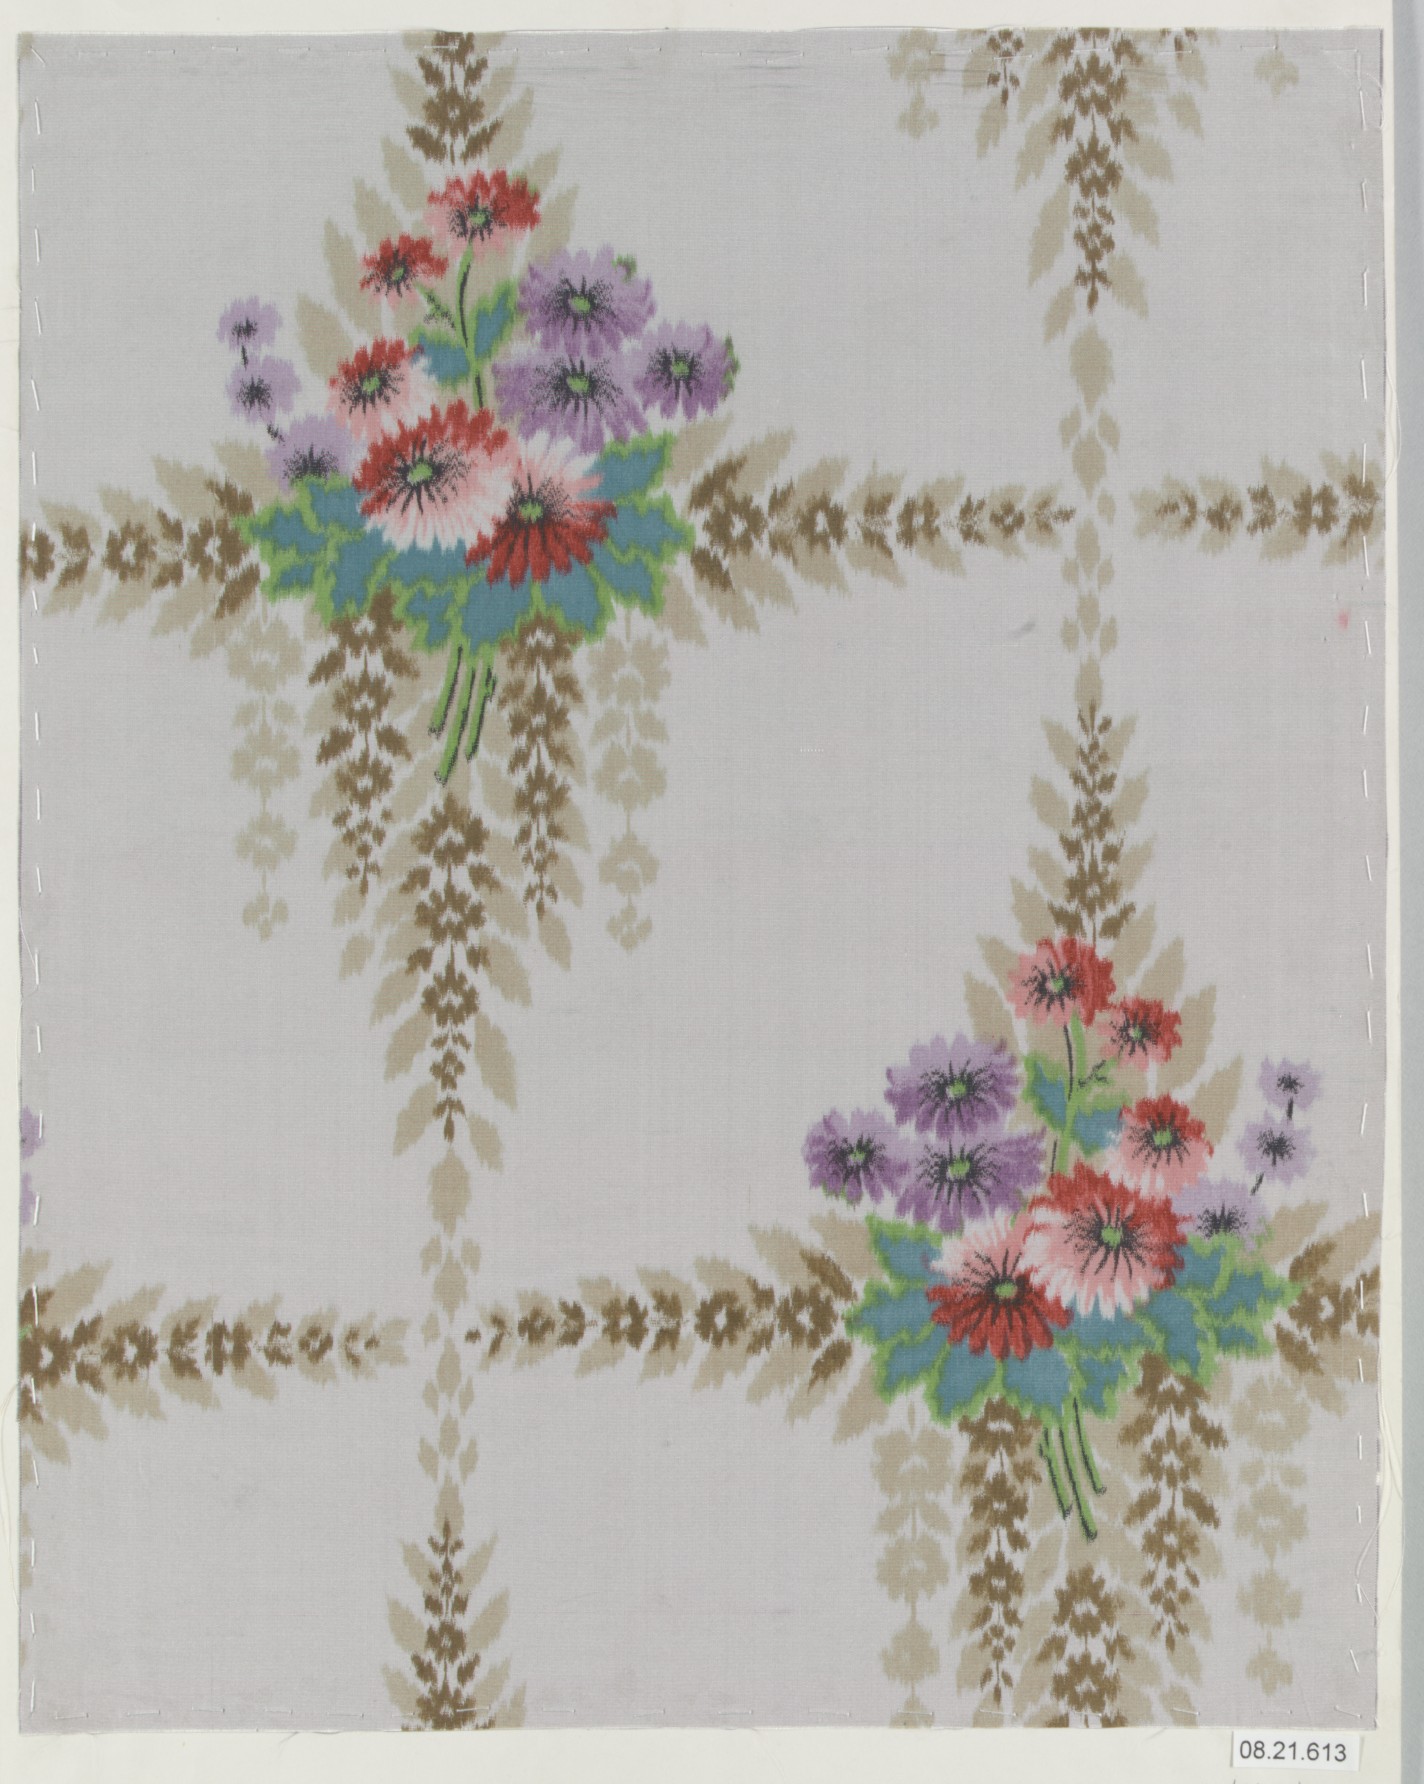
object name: textile sample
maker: Anonymous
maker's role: designer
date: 1900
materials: silk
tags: flowers